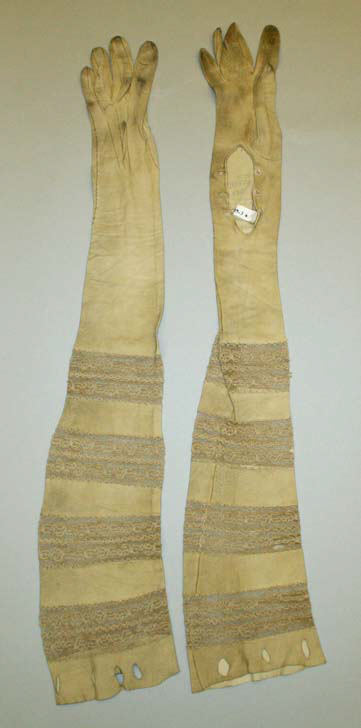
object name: glove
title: Gloves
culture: french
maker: bon marché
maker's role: department store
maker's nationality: french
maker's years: 1852-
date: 1900